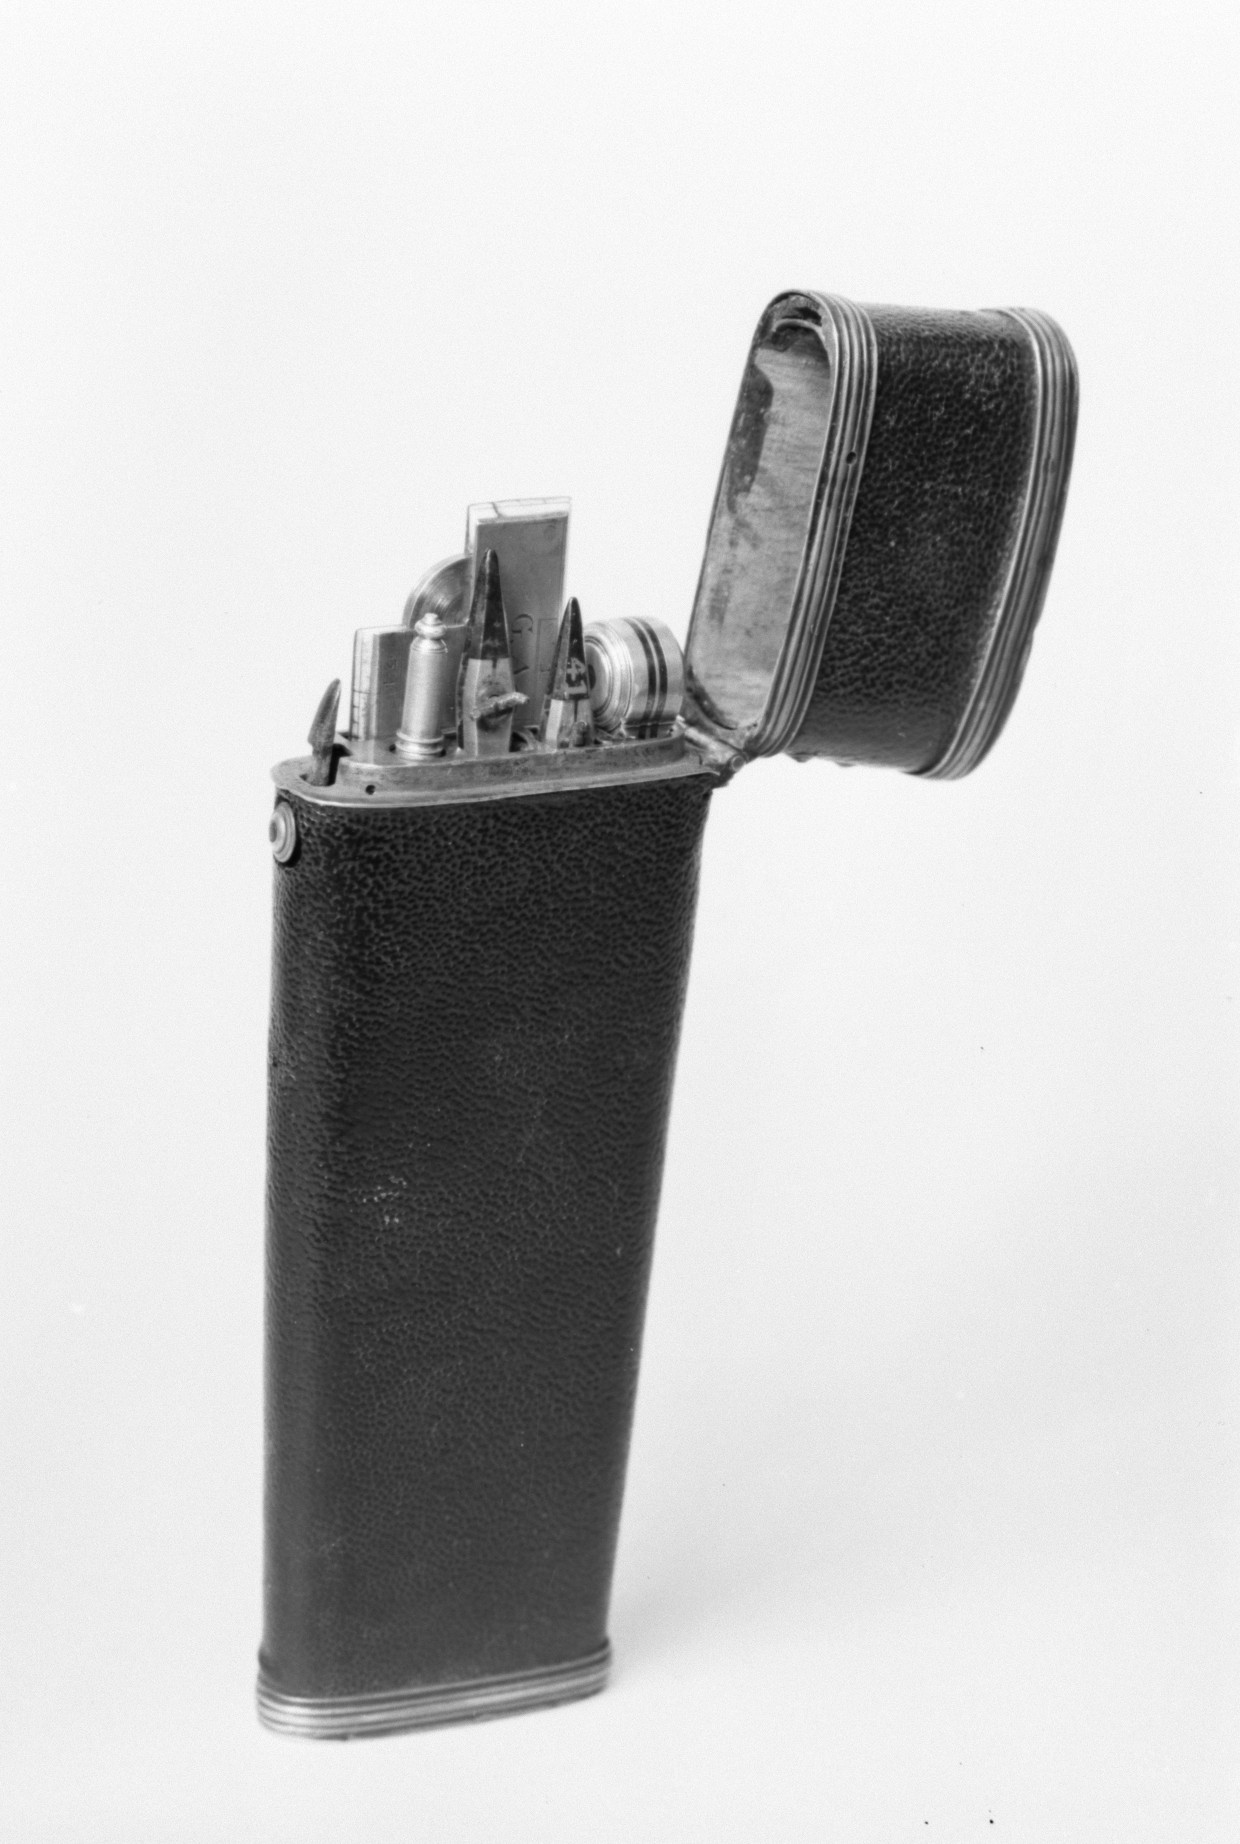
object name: draughtsman's instrument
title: Draughtsman's instruments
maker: george adams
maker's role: maker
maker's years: 1739-1752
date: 1701-1800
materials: brass, ivory, silver